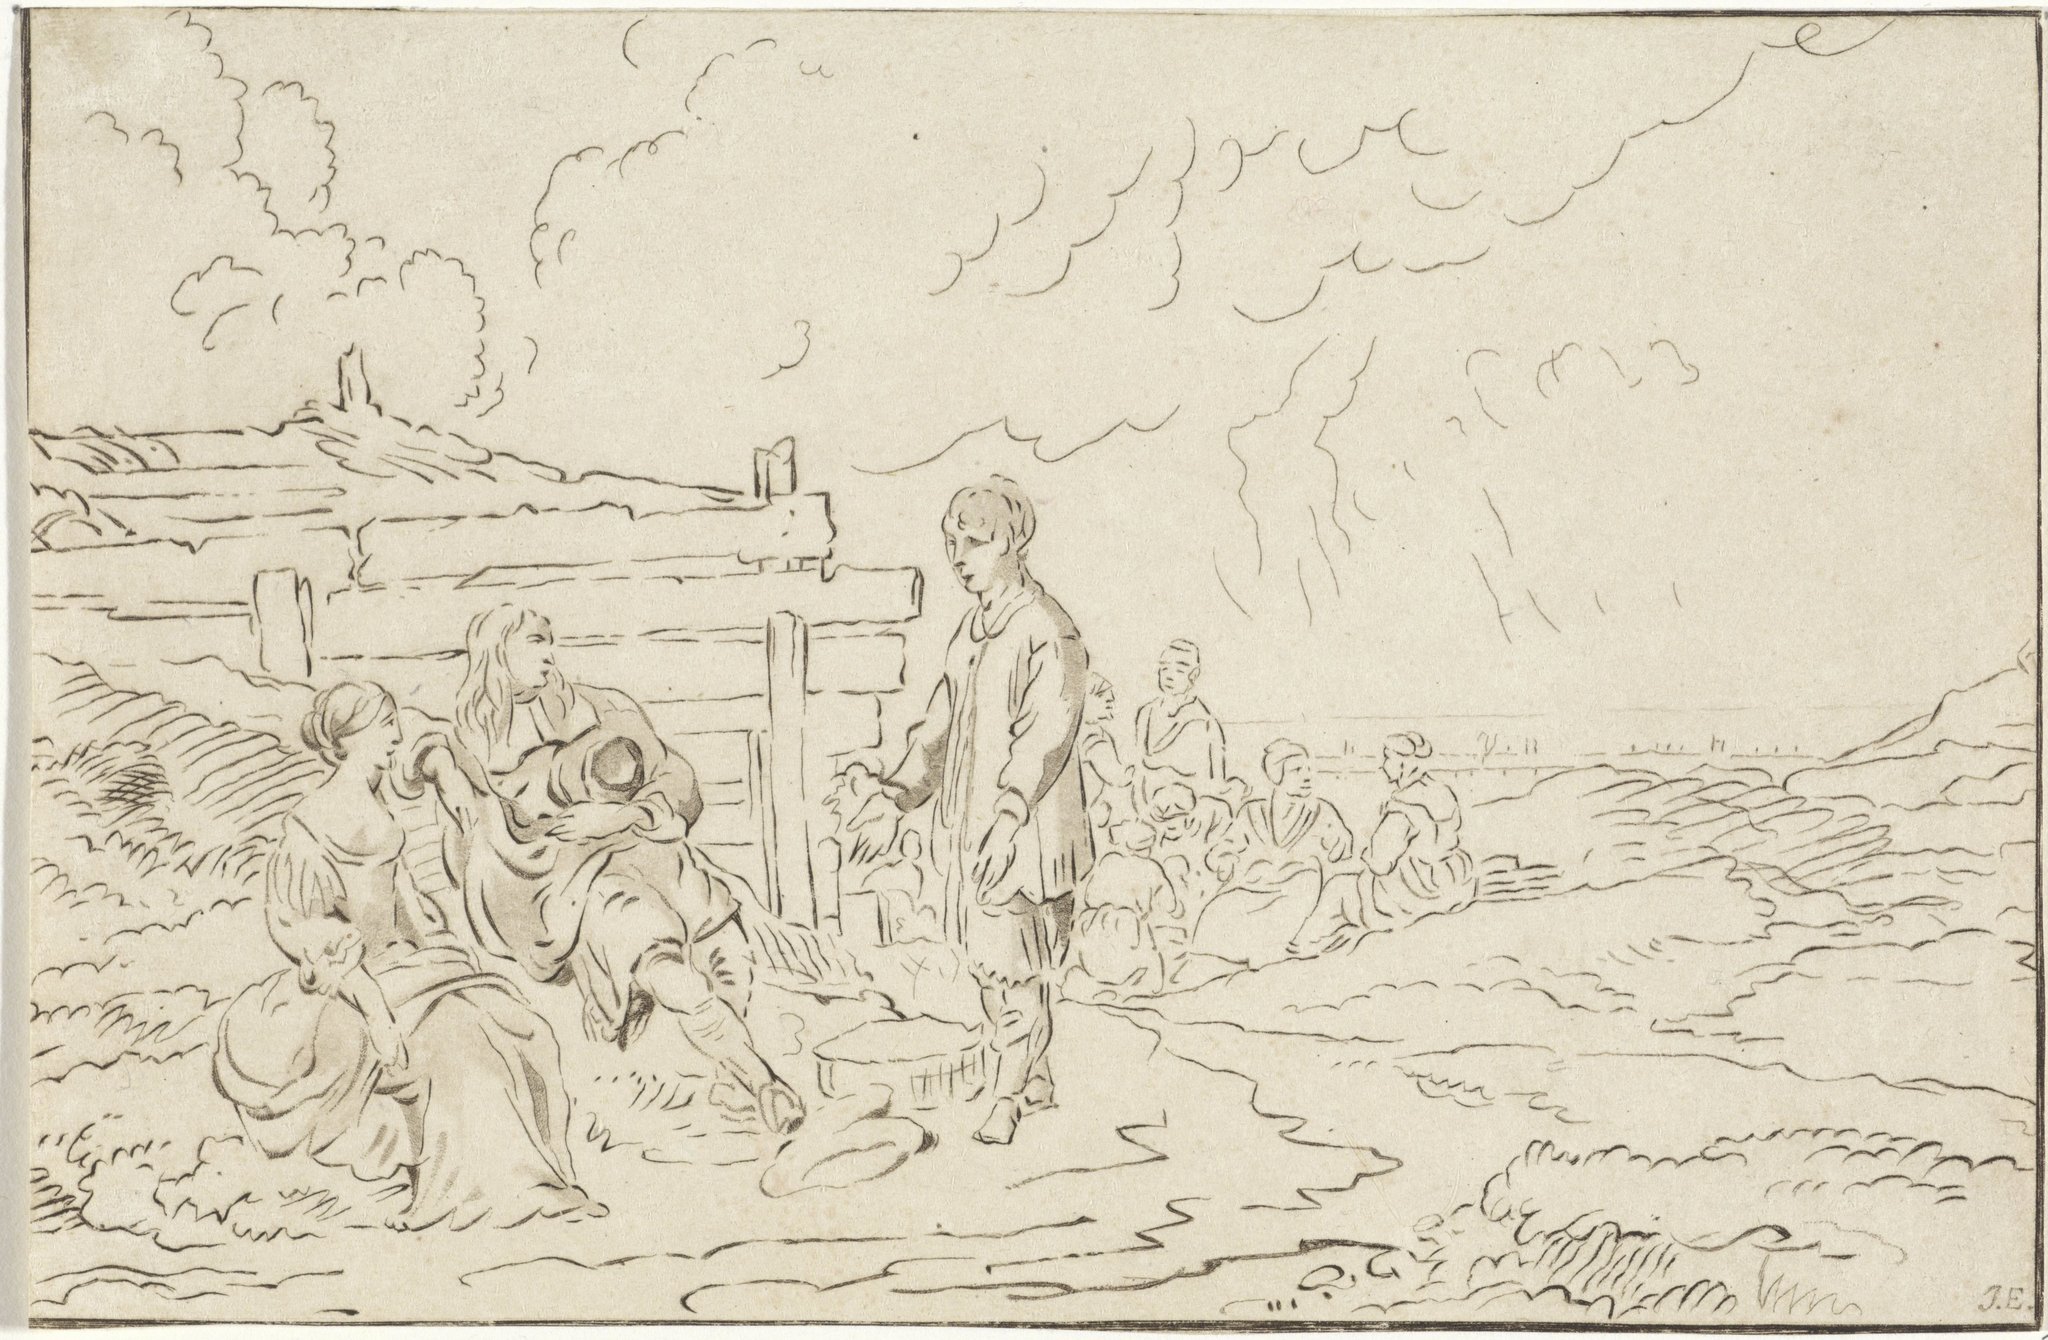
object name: print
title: Gezelschap in de duinen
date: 1767-1780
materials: paper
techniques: etching, rocker stamped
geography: netherlands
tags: recreation in the dunes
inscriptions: collector's mark: Lugt 240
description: Bij een schutting zitten een man en een vrouw. Zij spreken met een jongen die bij hen staat. Op de achtergrond zit een andere groep mensen in de duinen.